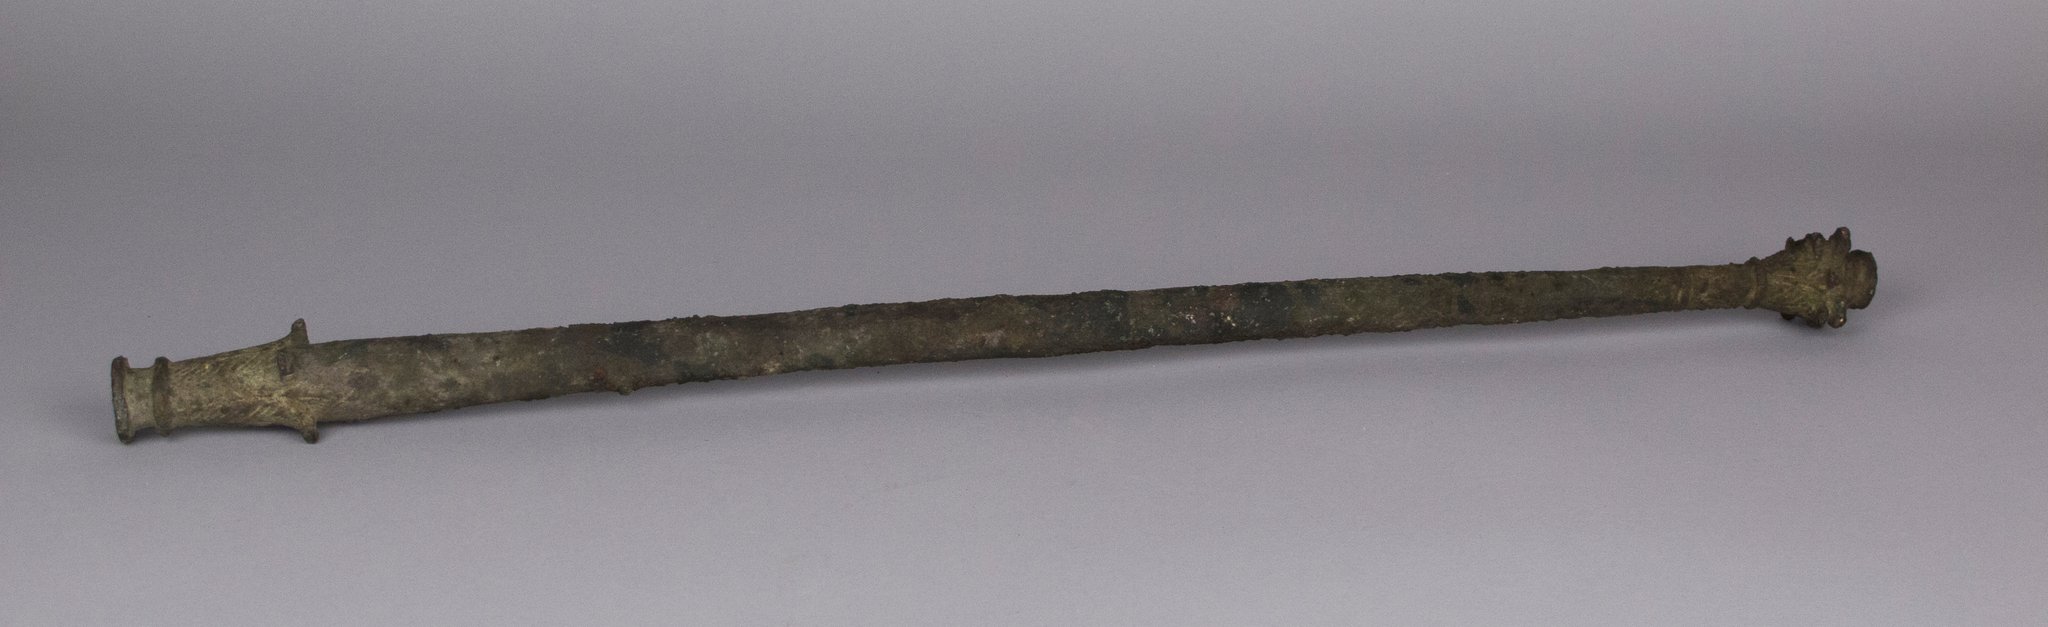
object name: shepherd's crook or staff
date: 7000 BCE-330 CE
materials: bronze